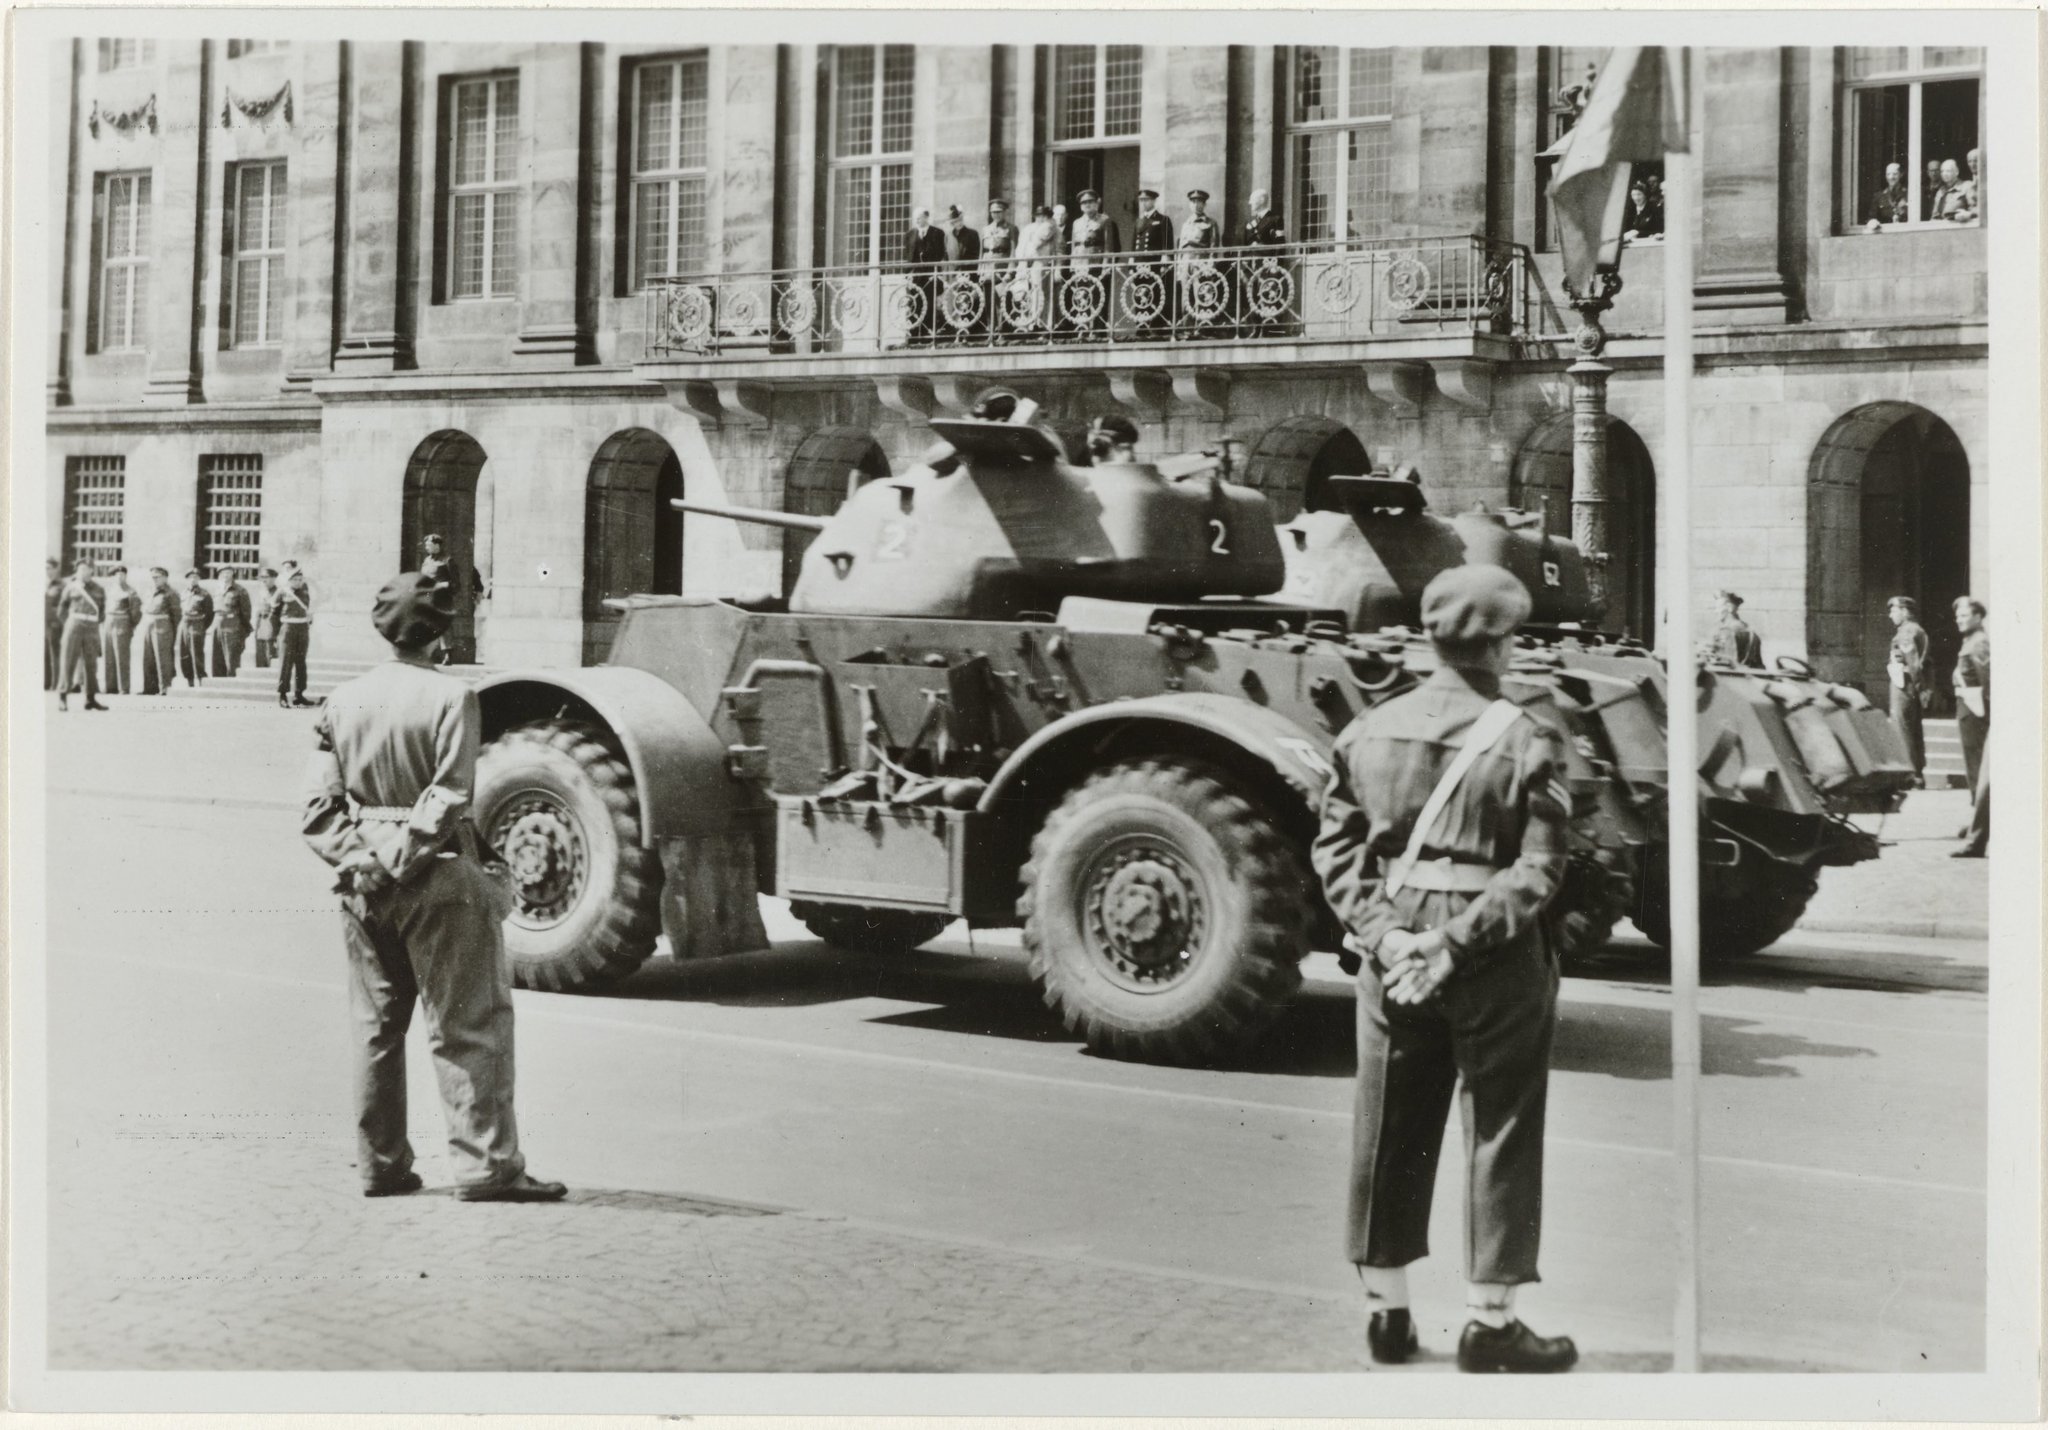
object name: photograph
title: Defilé op de Dam te Amsterdam bij de bevrijdingsfeesten op 28 juni 1945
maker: Anonymous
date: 1945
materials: photographic support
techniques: photography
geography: netherlands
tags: the hague, print maker, wilhelmina of the netherlands